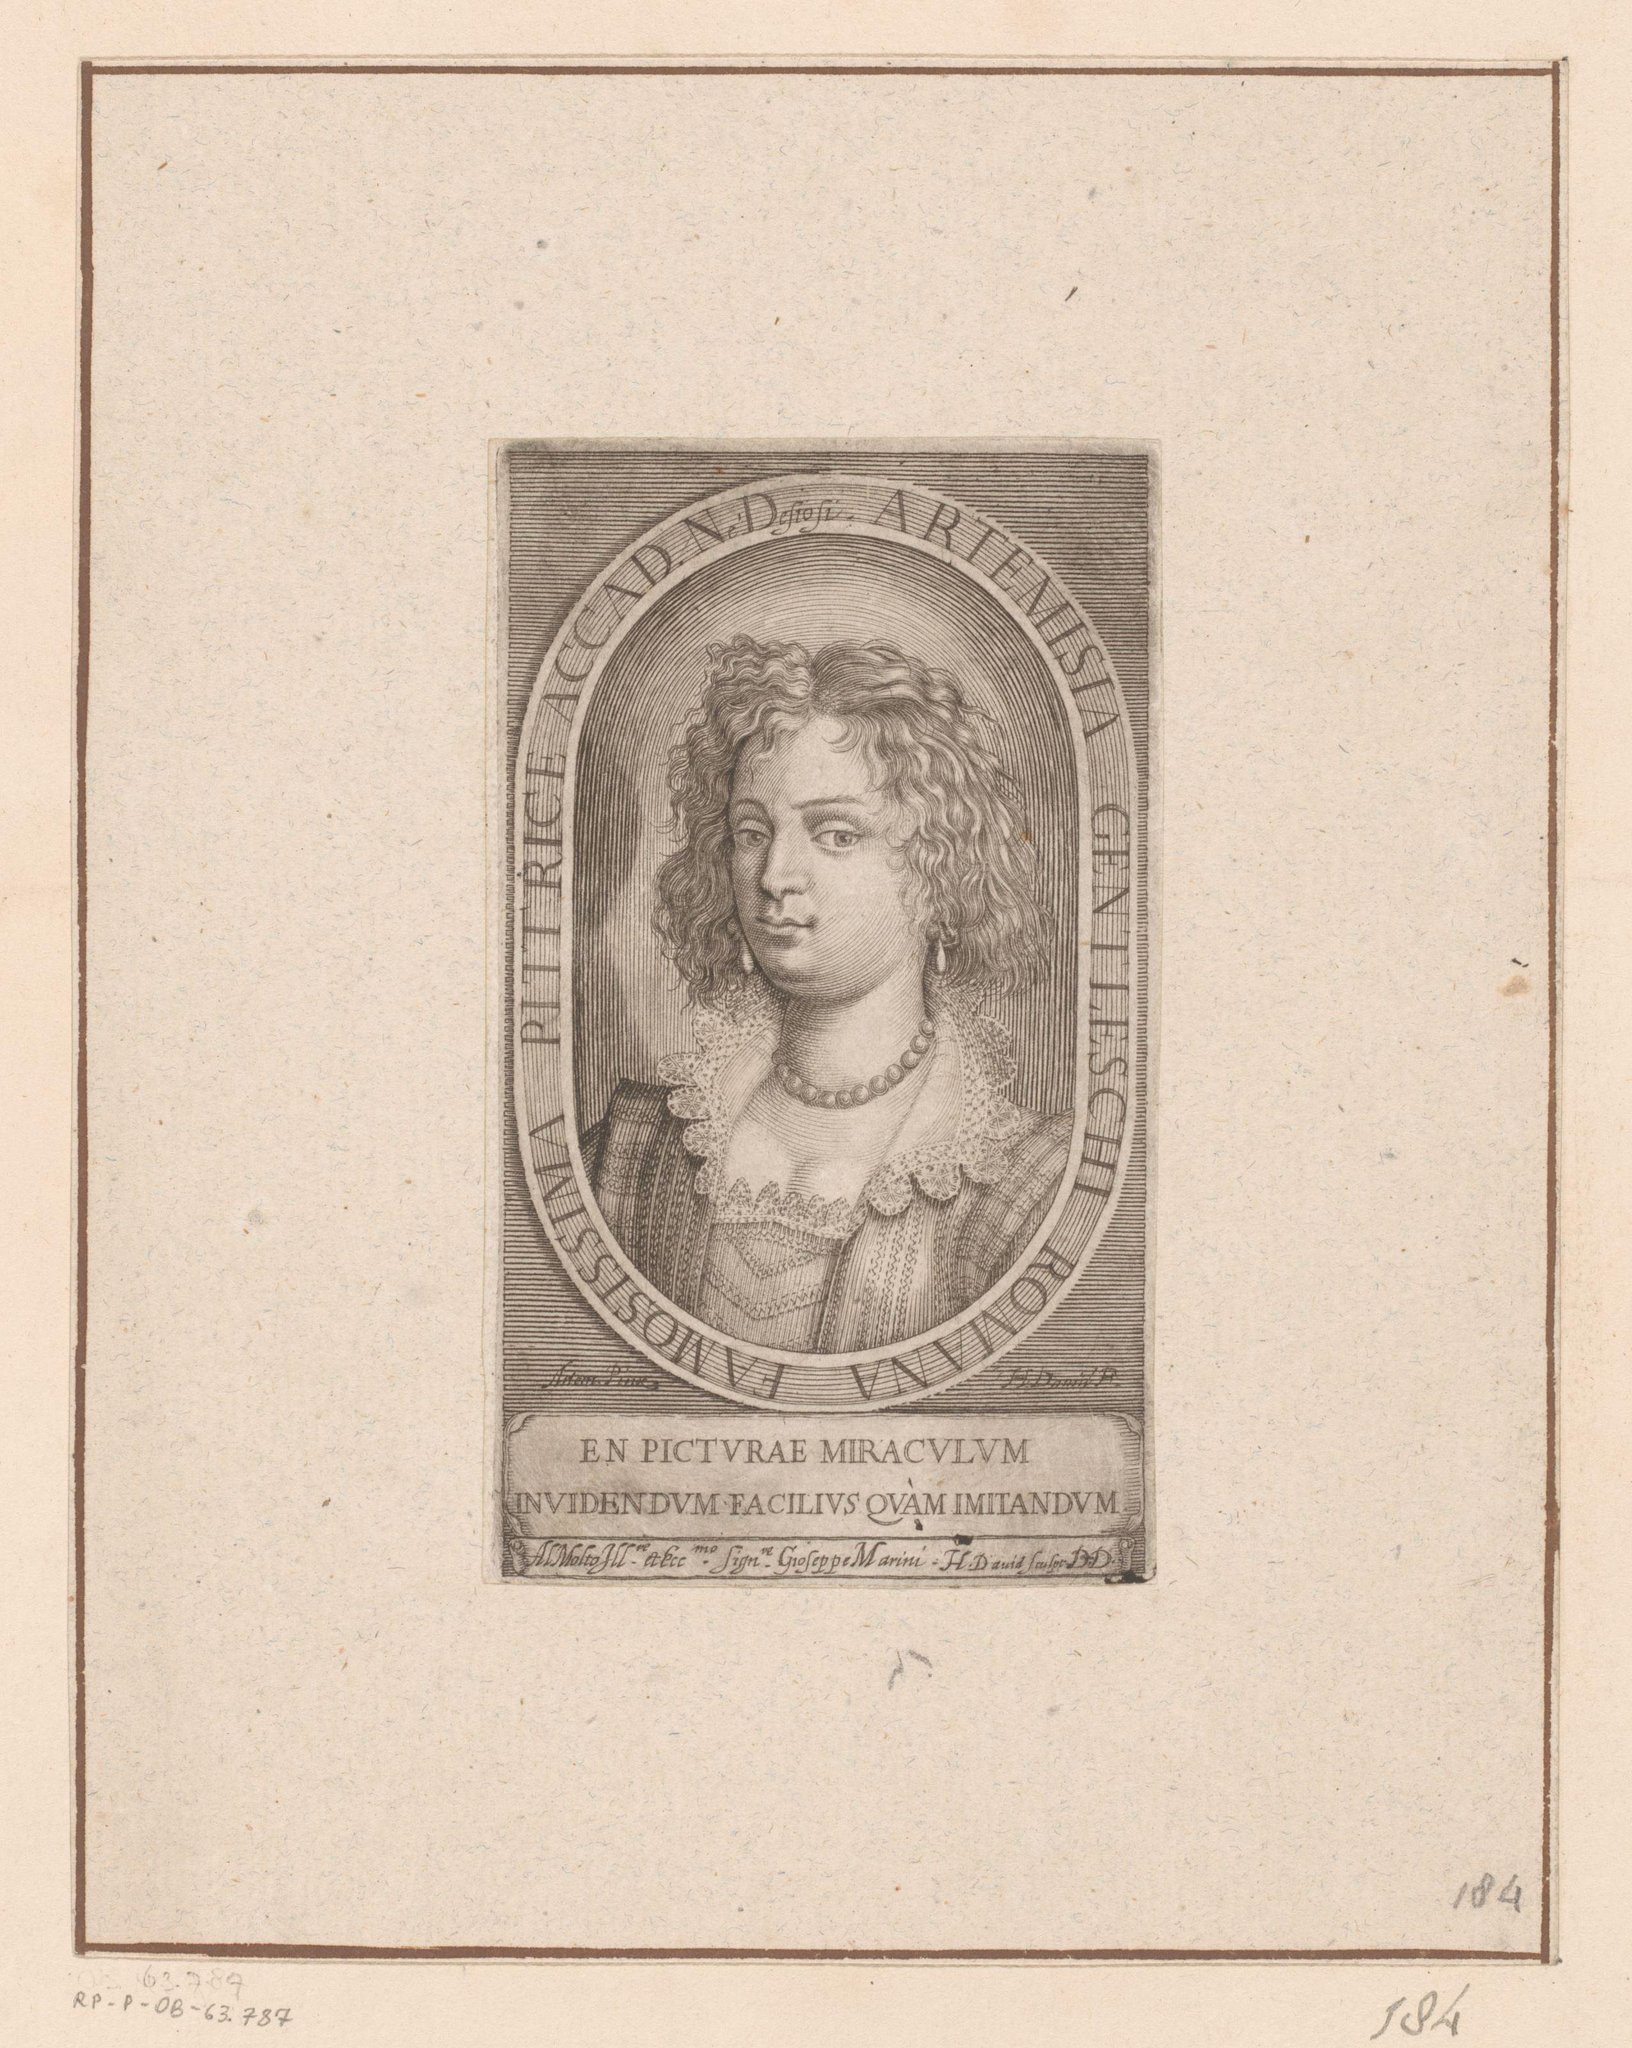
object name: print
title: Portret van Artemisia Gentileschi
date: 1615-1670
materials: paper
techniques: engraving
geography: france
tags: naples, painter, artemisia gentileschi, ornament ~ medallion, portrait, self-portrait of painter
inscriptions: collector's mark: Lugt 2165, collector's mark: Lugt 240